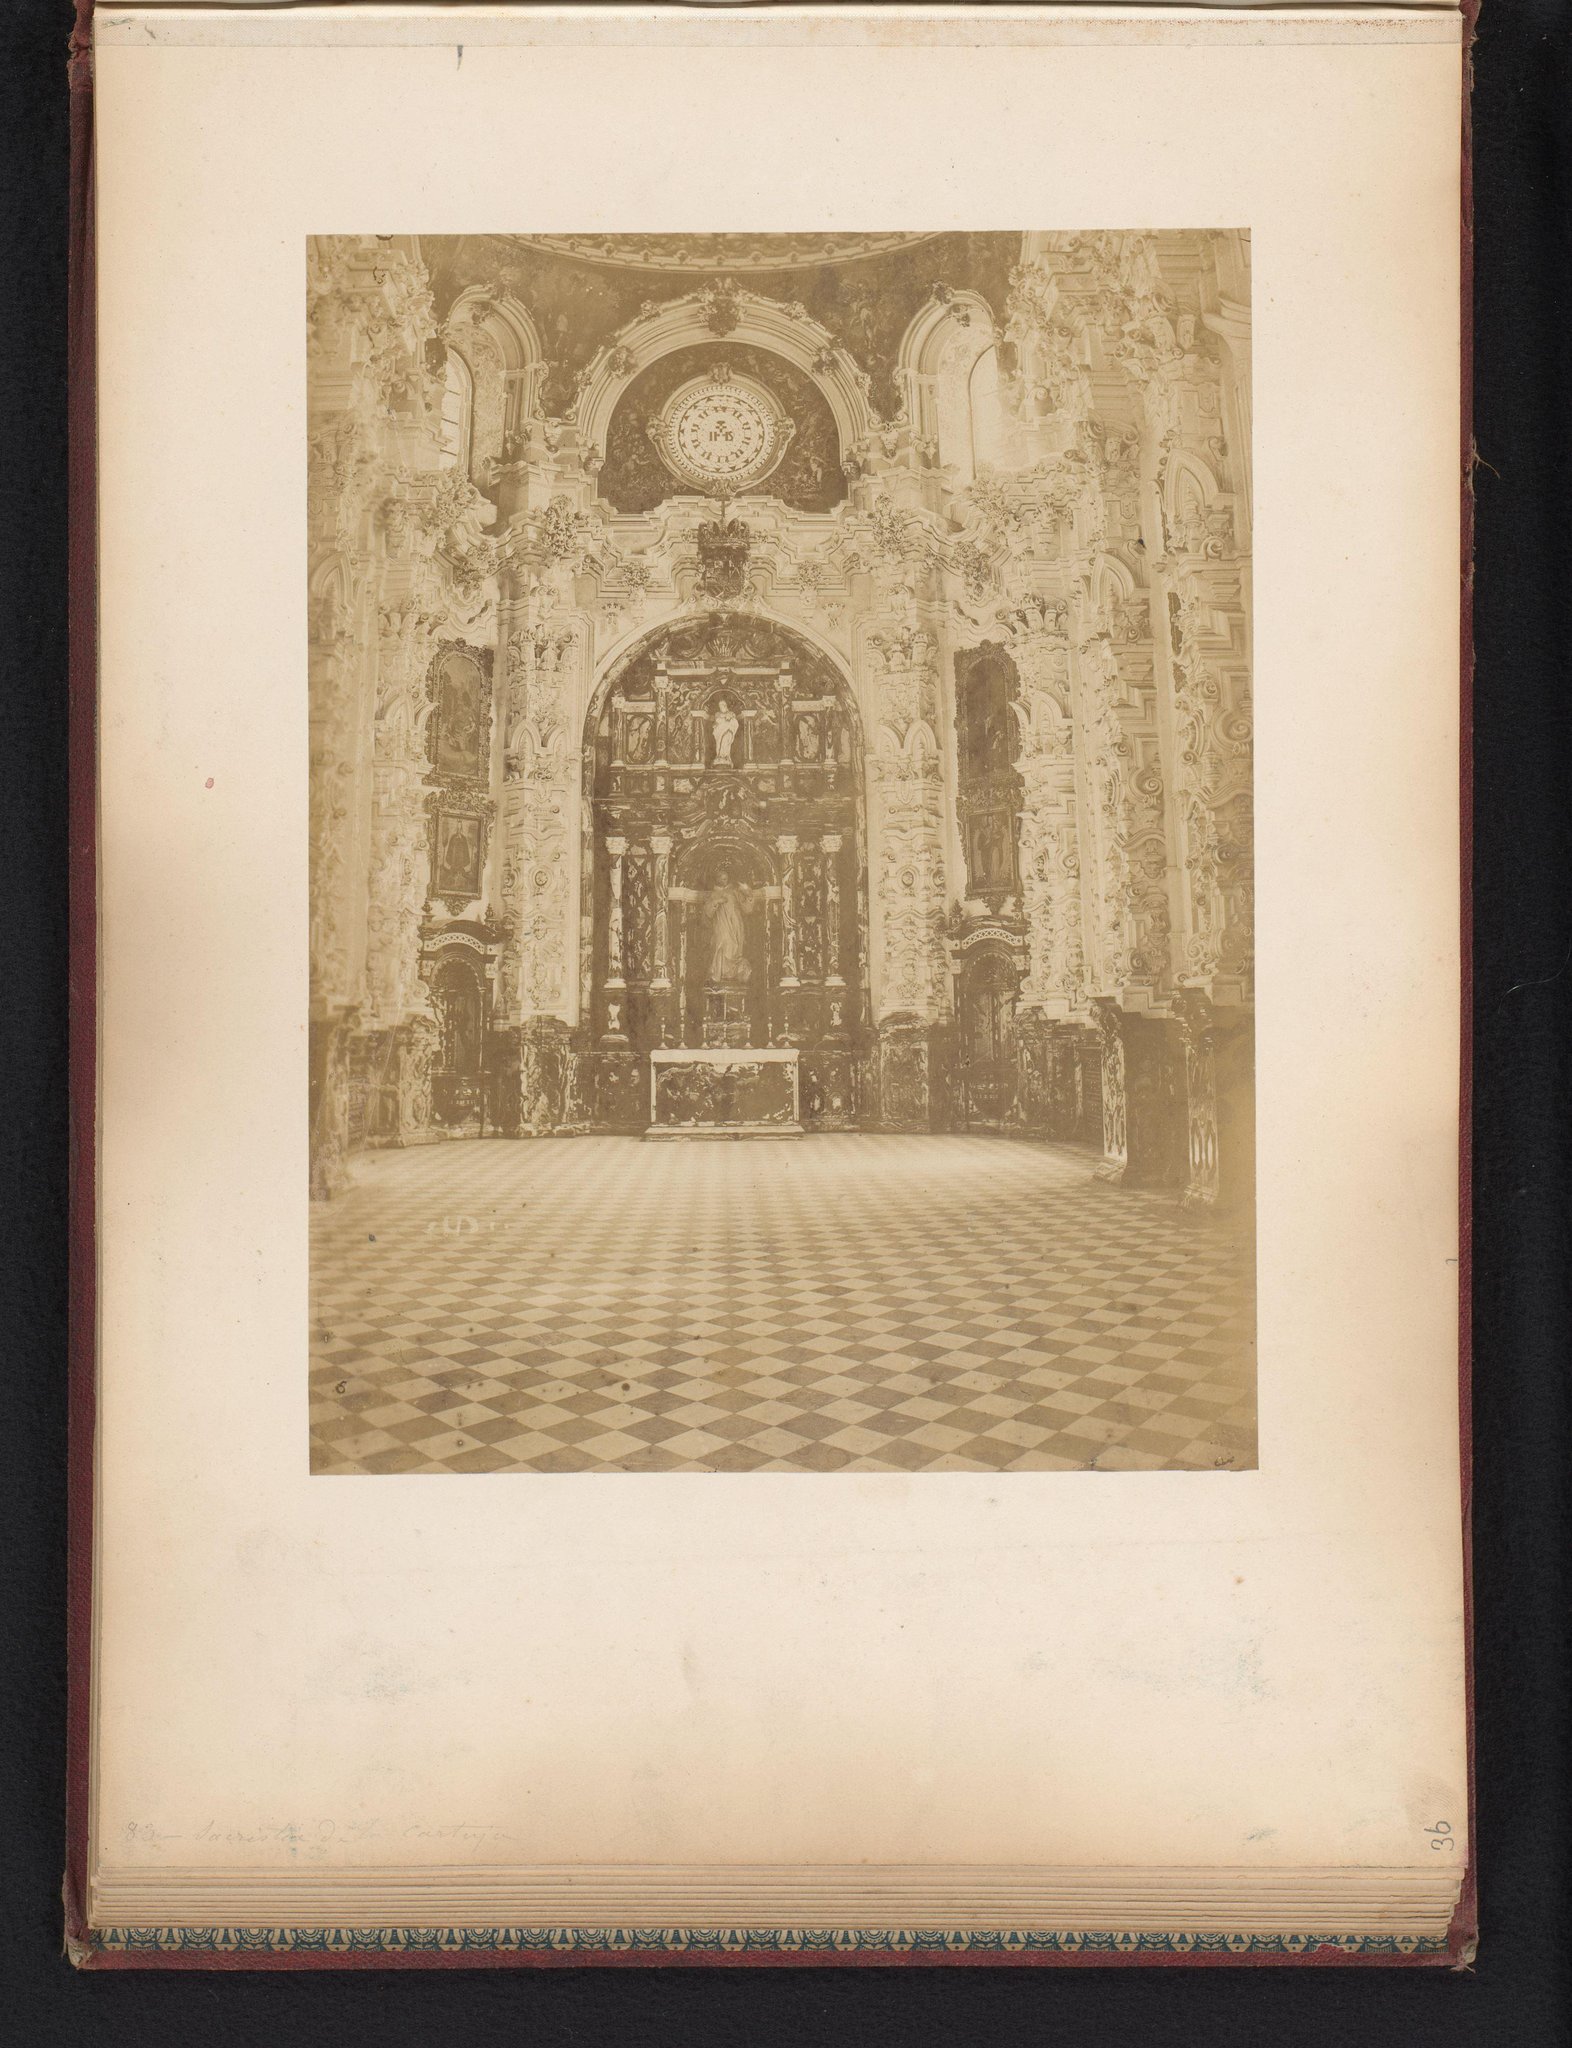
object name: photograph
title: Sacristie de la Cartuja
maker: c maufsaise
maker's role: fotograaf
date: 1906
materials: paper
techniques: albumen print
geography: granada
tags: parts of church interior: sacristy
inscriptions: number: ‘83’